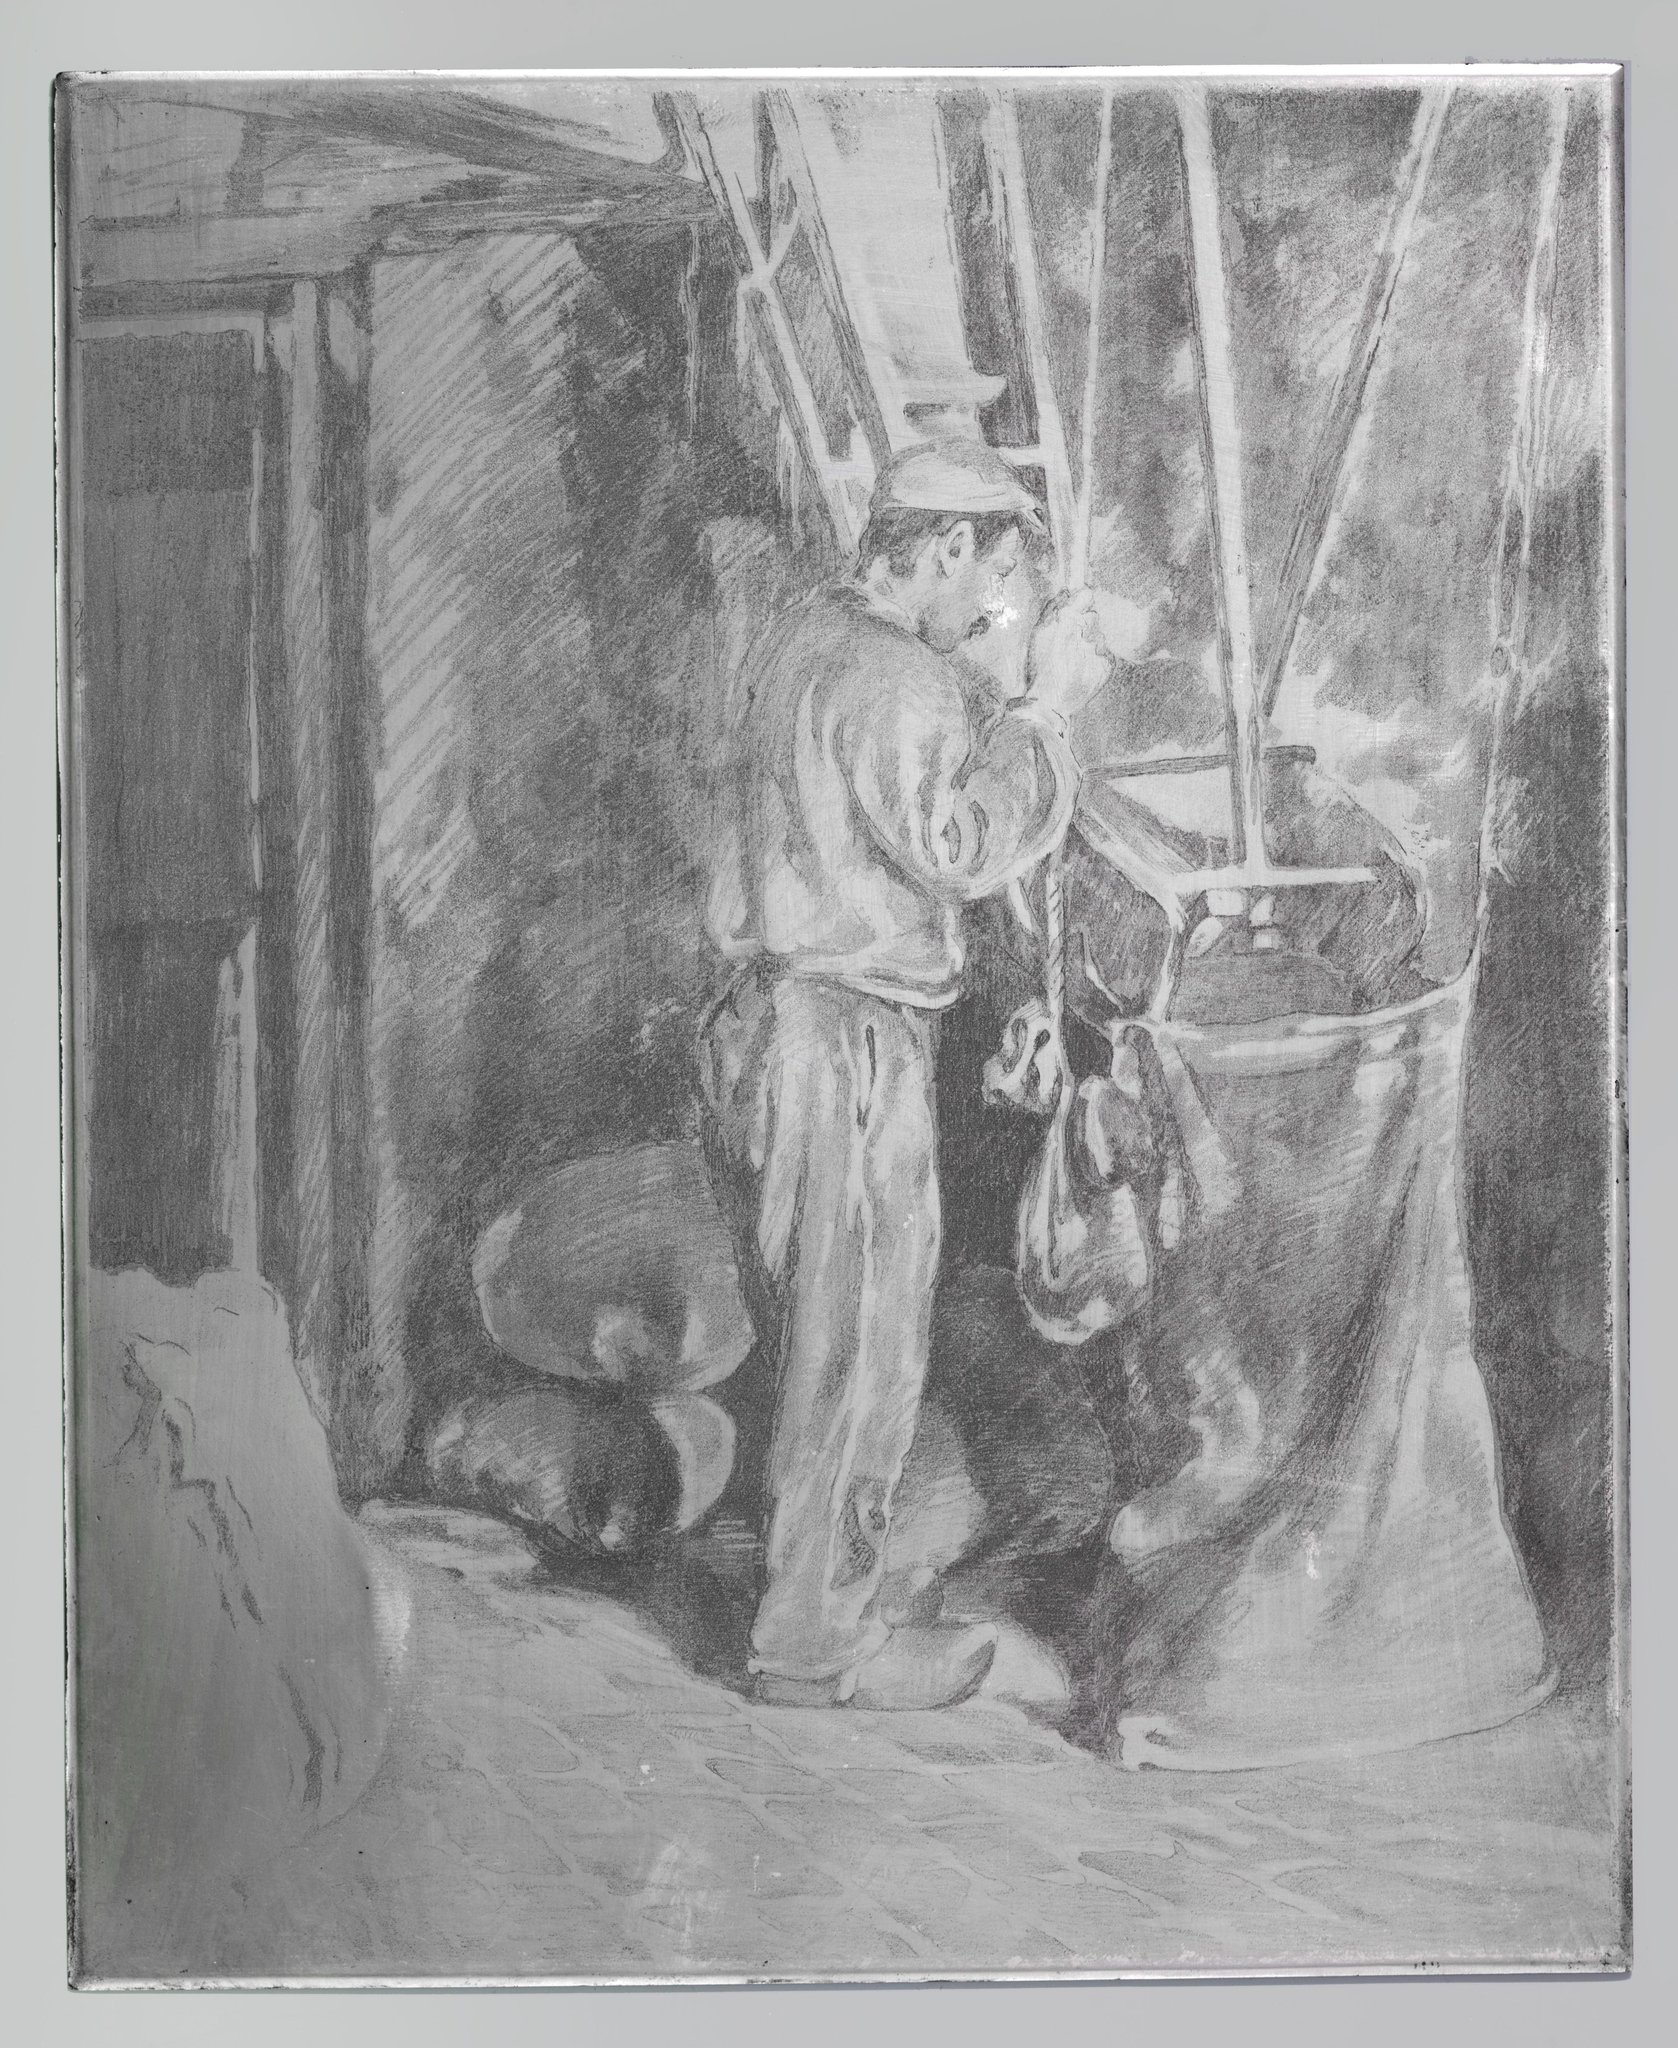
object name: copper plate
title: Molenaar, dichte deur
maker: willem witsen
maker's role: draughtsman, painter, print maker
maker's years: 1860-1923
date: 1910-1911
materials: copper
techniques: soft ground etching